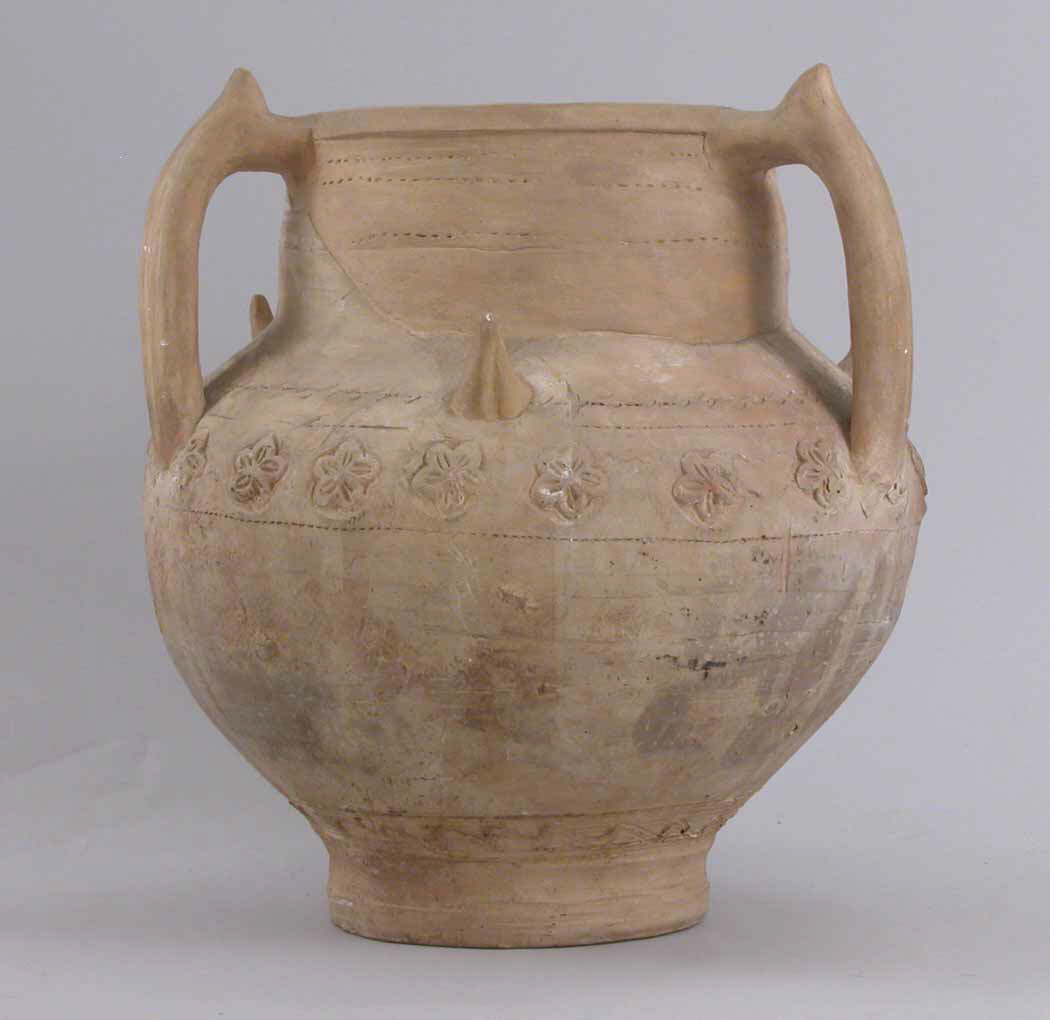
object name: jug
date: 801-900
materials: earthenware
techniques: incising, stamping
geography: iran